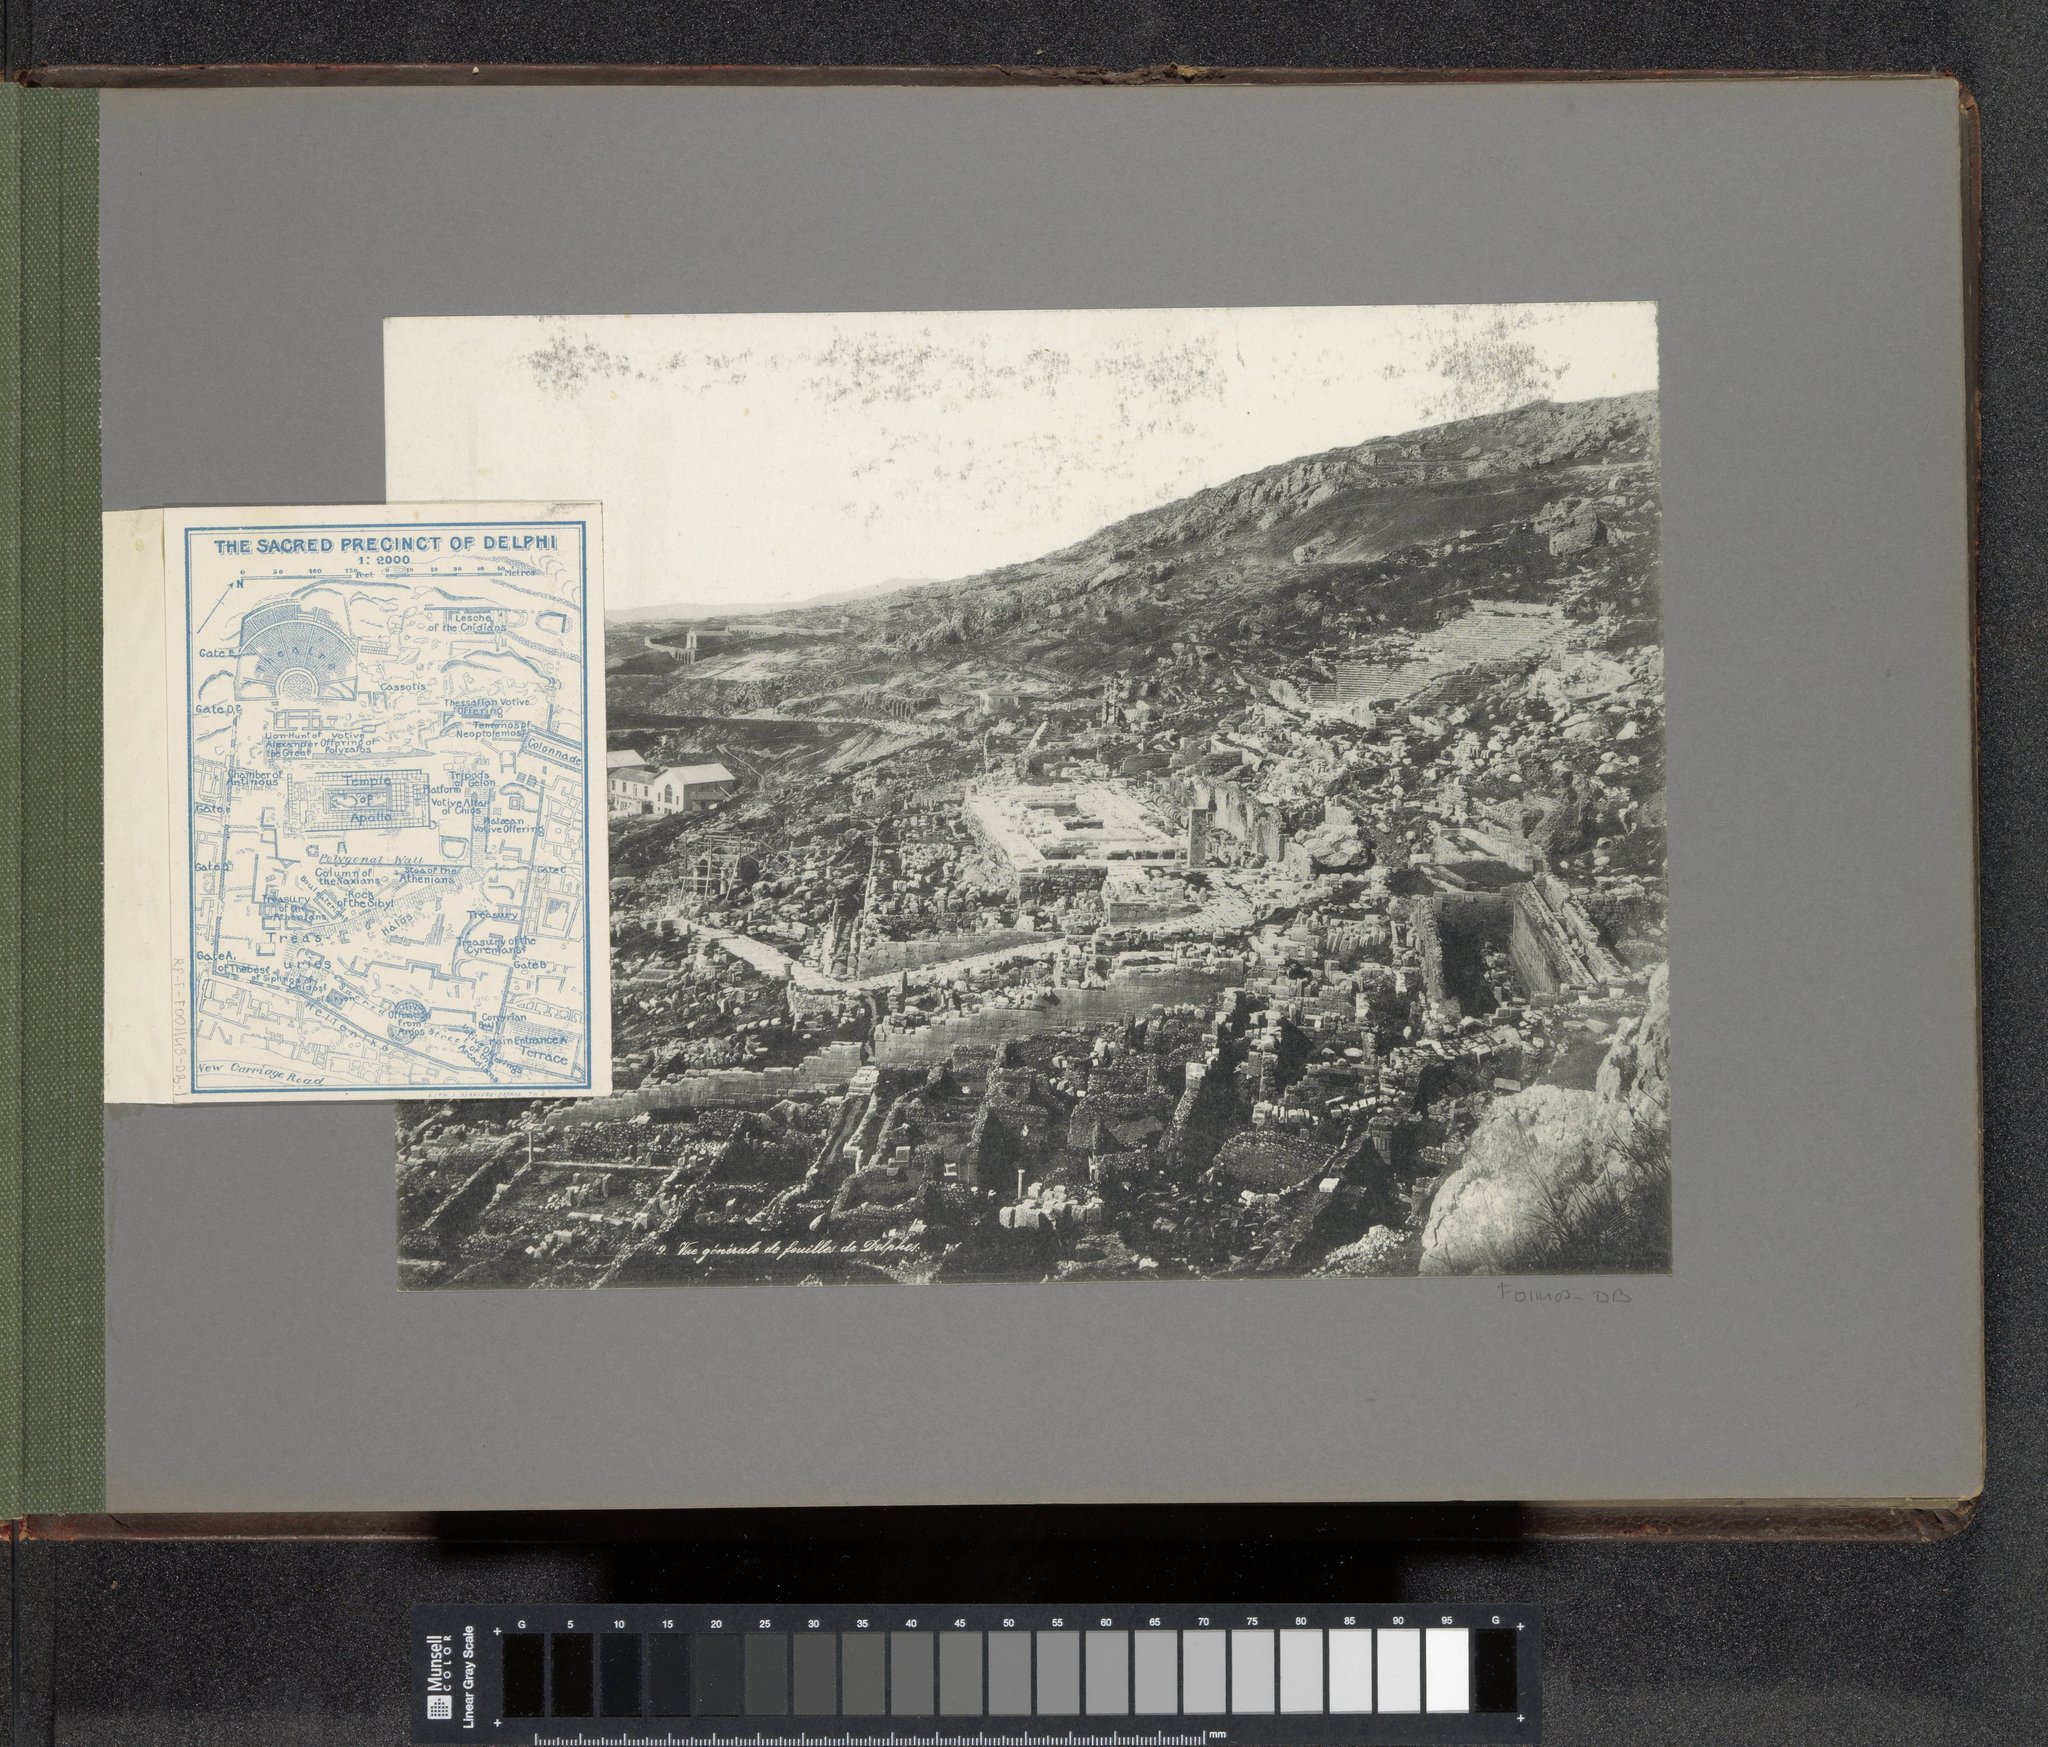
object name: photograph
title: Gezicht op de opgravingen van Delphi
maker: Anonymous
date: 1895-1905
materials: paper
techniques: photograph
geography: delphi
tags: excavation ~ archaeology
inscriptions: number: ‘9’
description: Onderdeel van Reisalbum met foto's van bezienswaardigheden in Griekenland en Egypte.